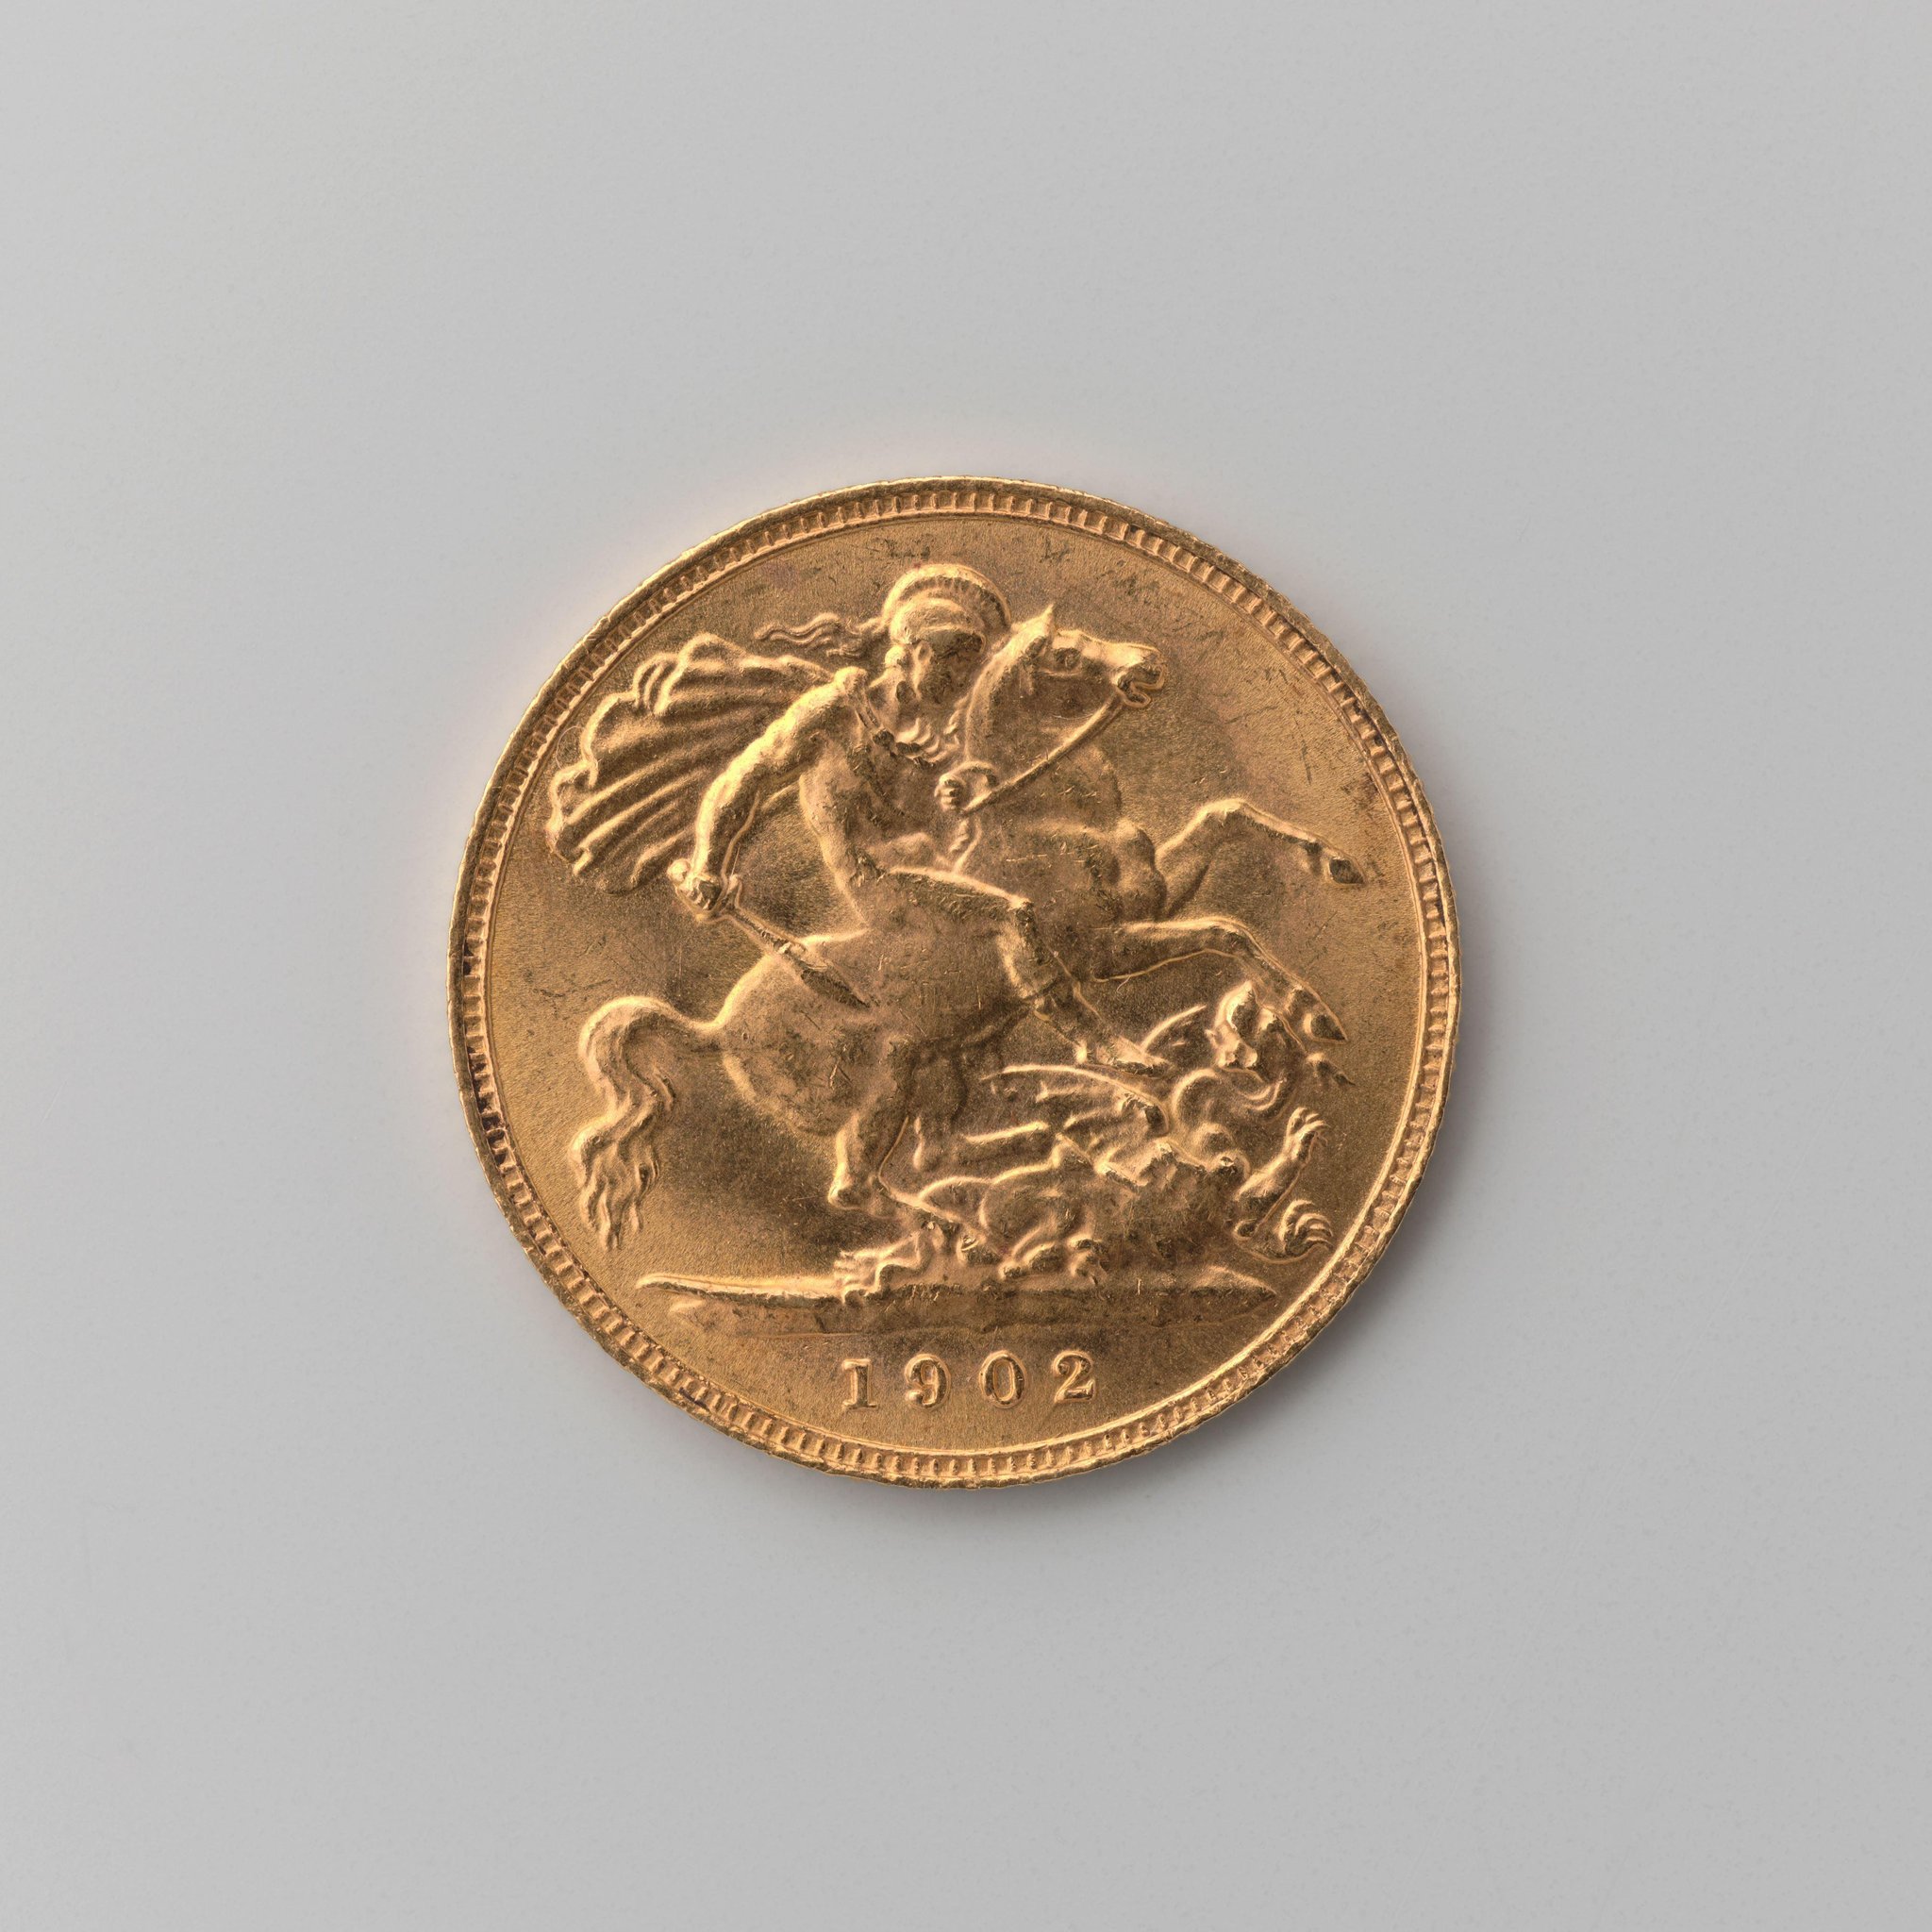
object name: halve sovereign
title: Engeland, Edward VII, ½ sovereign, 1902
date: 1902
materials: gold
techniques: striking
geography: london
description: Gouden munt. Voorzijde: gekroond hoofd van de koningin naar rechts. Keerzijde: Sint Joris te paard naar rechts, de draak onder zich met lans doorstekend. Jaartal in afsnede onderaan. Kartelrand.